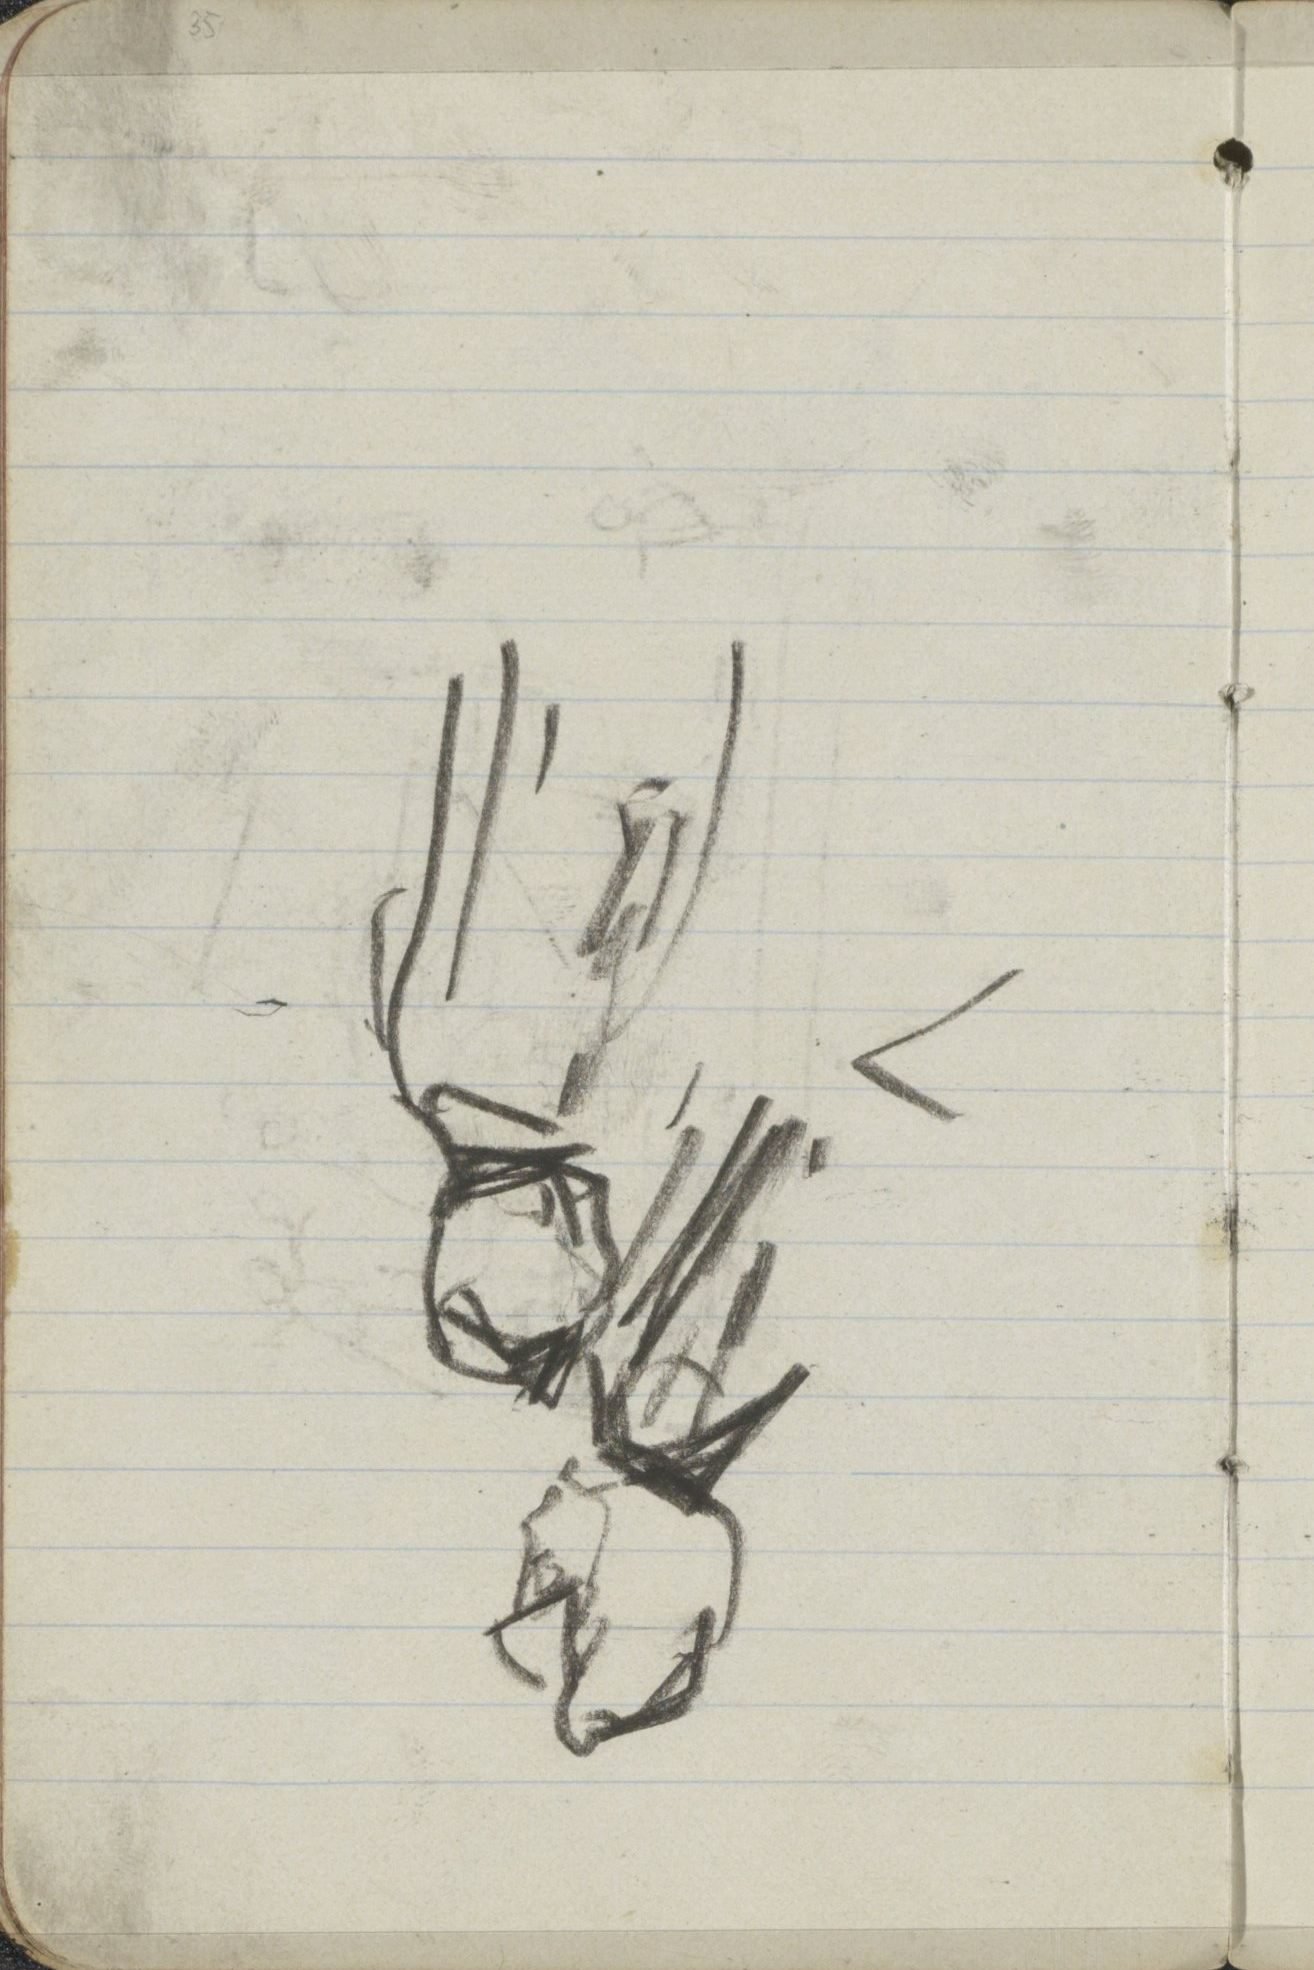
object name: sketchbook leaf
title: Figuurstudies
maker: george hendrik breitner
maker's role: draughtsman, painter, print maker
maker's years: 1857-1923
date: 1894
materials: chalk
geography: amsterdam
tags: girl (child between toddler and youth)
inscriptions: kleurnotitie, handgeschreven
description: Pagina 35 uit een schetsboek met 31 bladen.